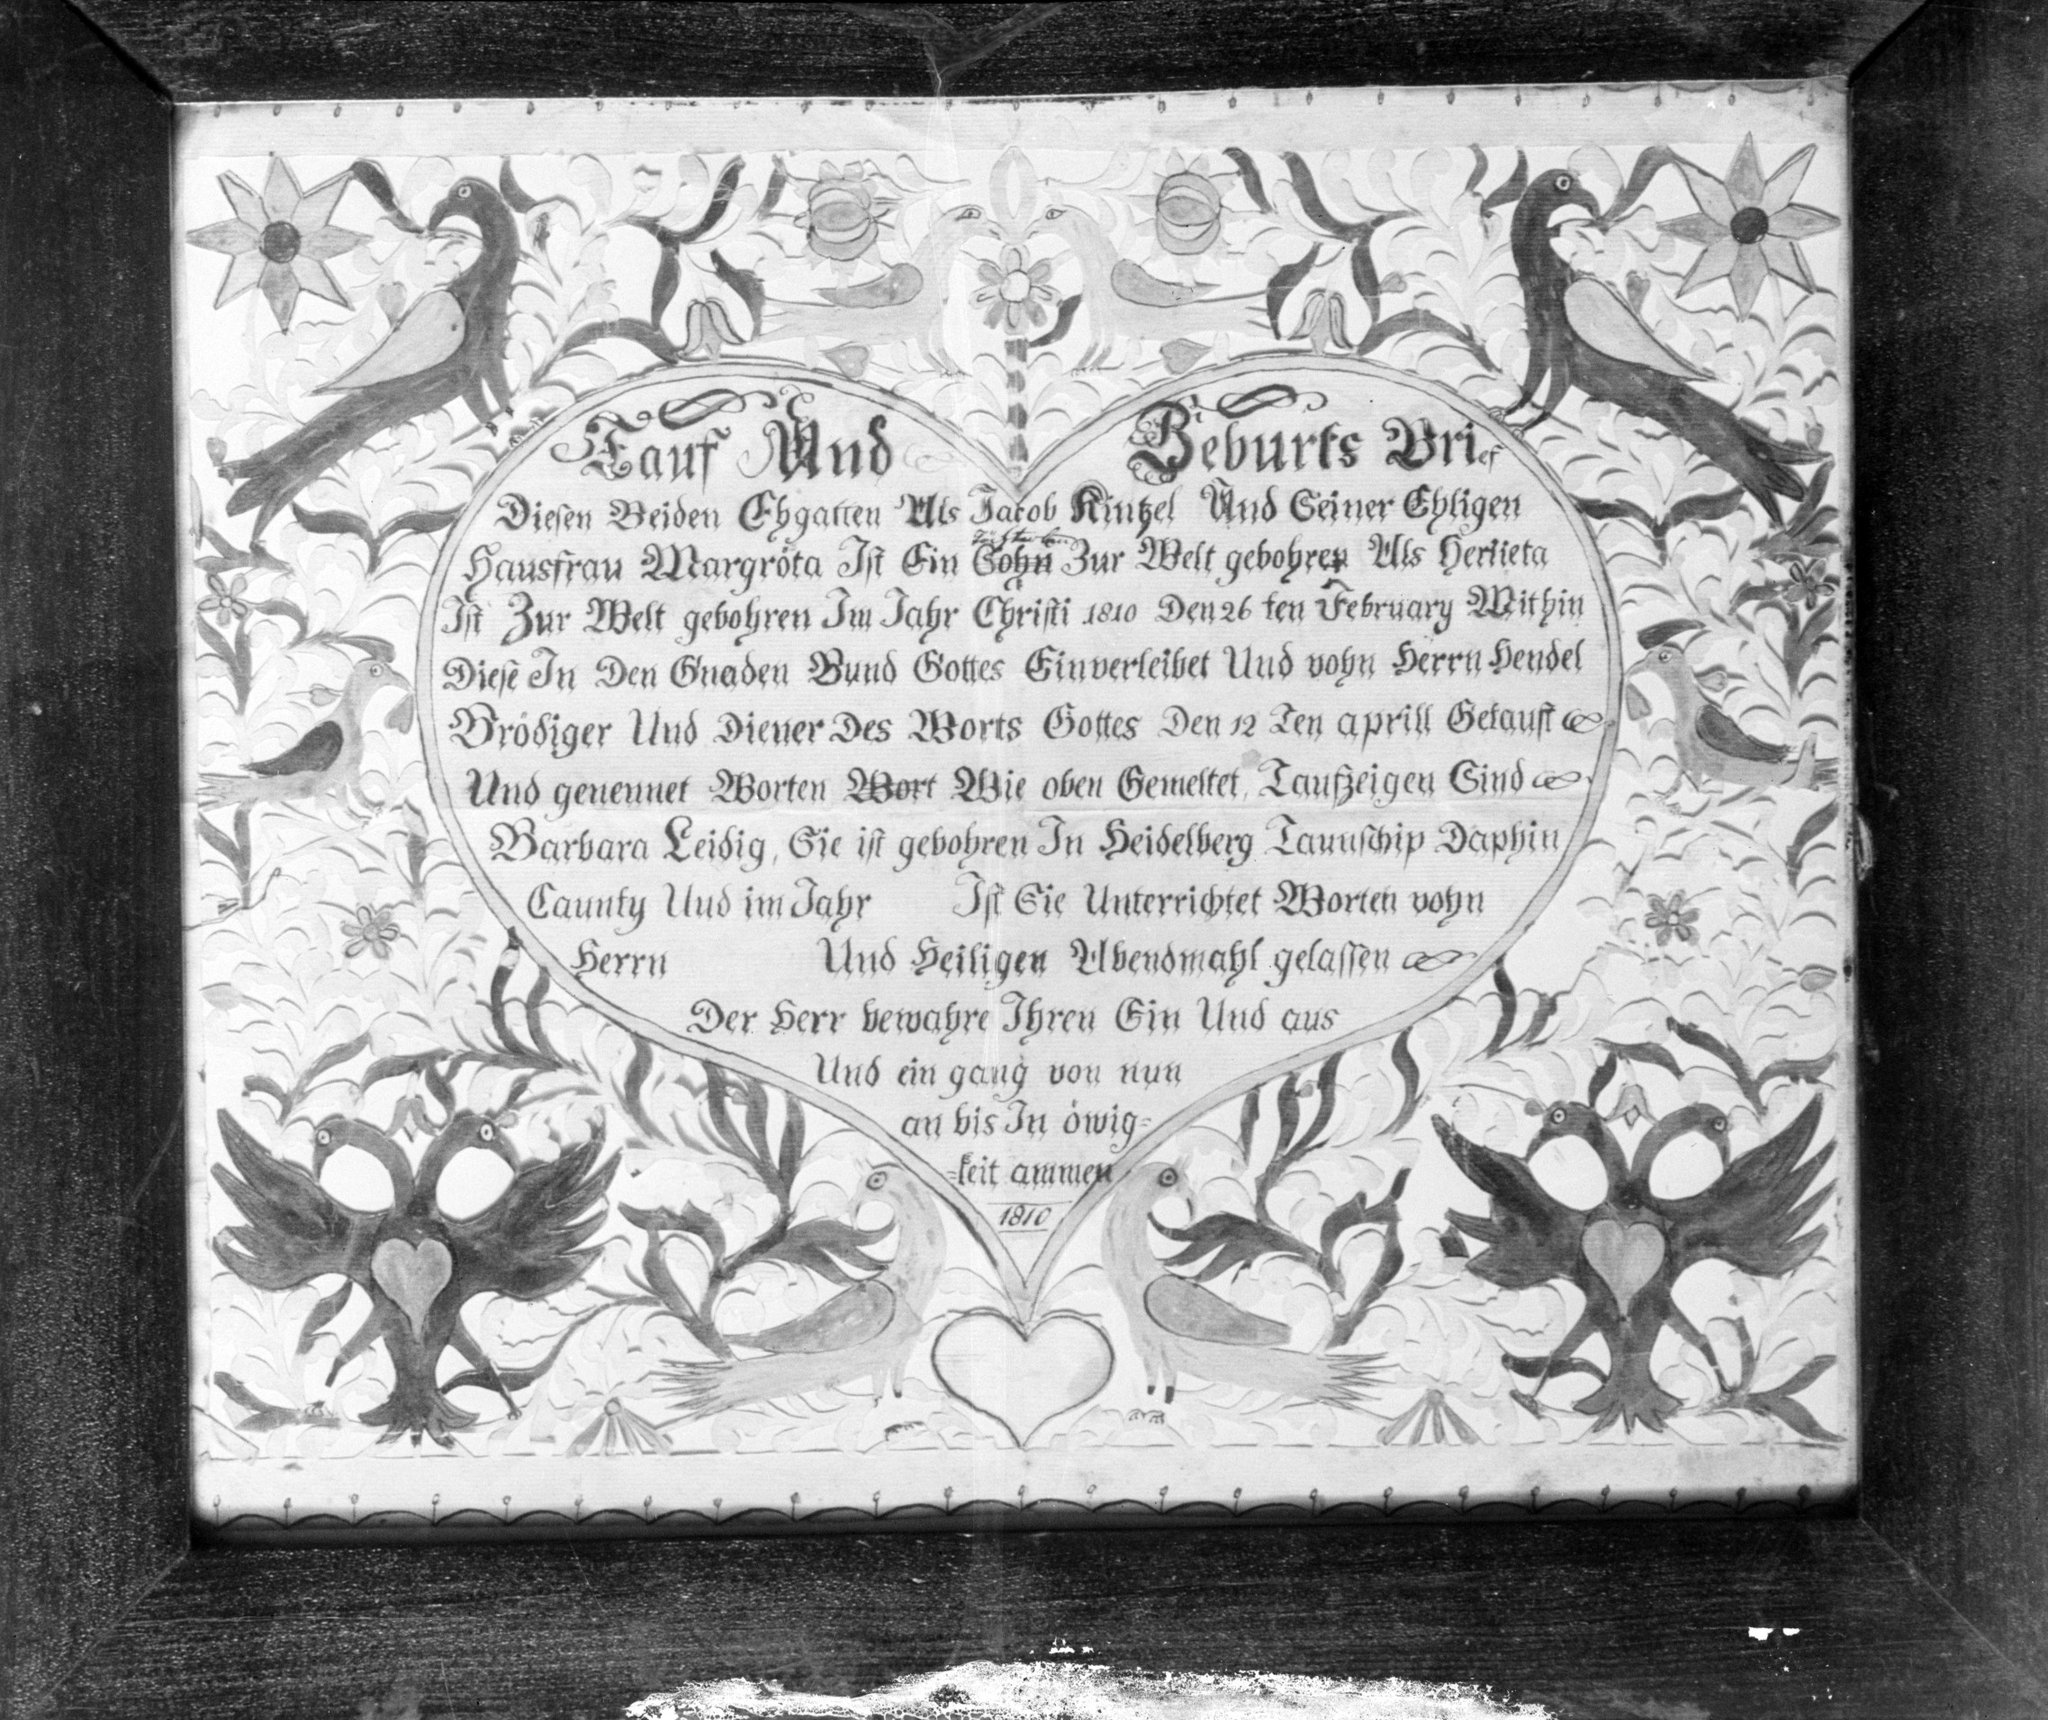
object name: birth and baptismal certificate, fraktur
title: Birth and Baptismal Certificate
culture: american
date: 1810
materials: ink, paper, watercolor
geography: united states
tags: birds